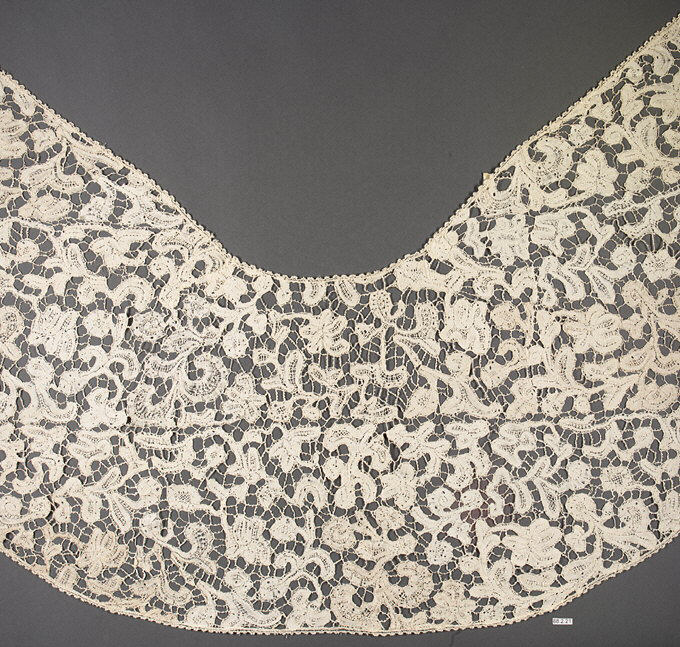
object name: cape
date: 1650-1700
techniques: lace